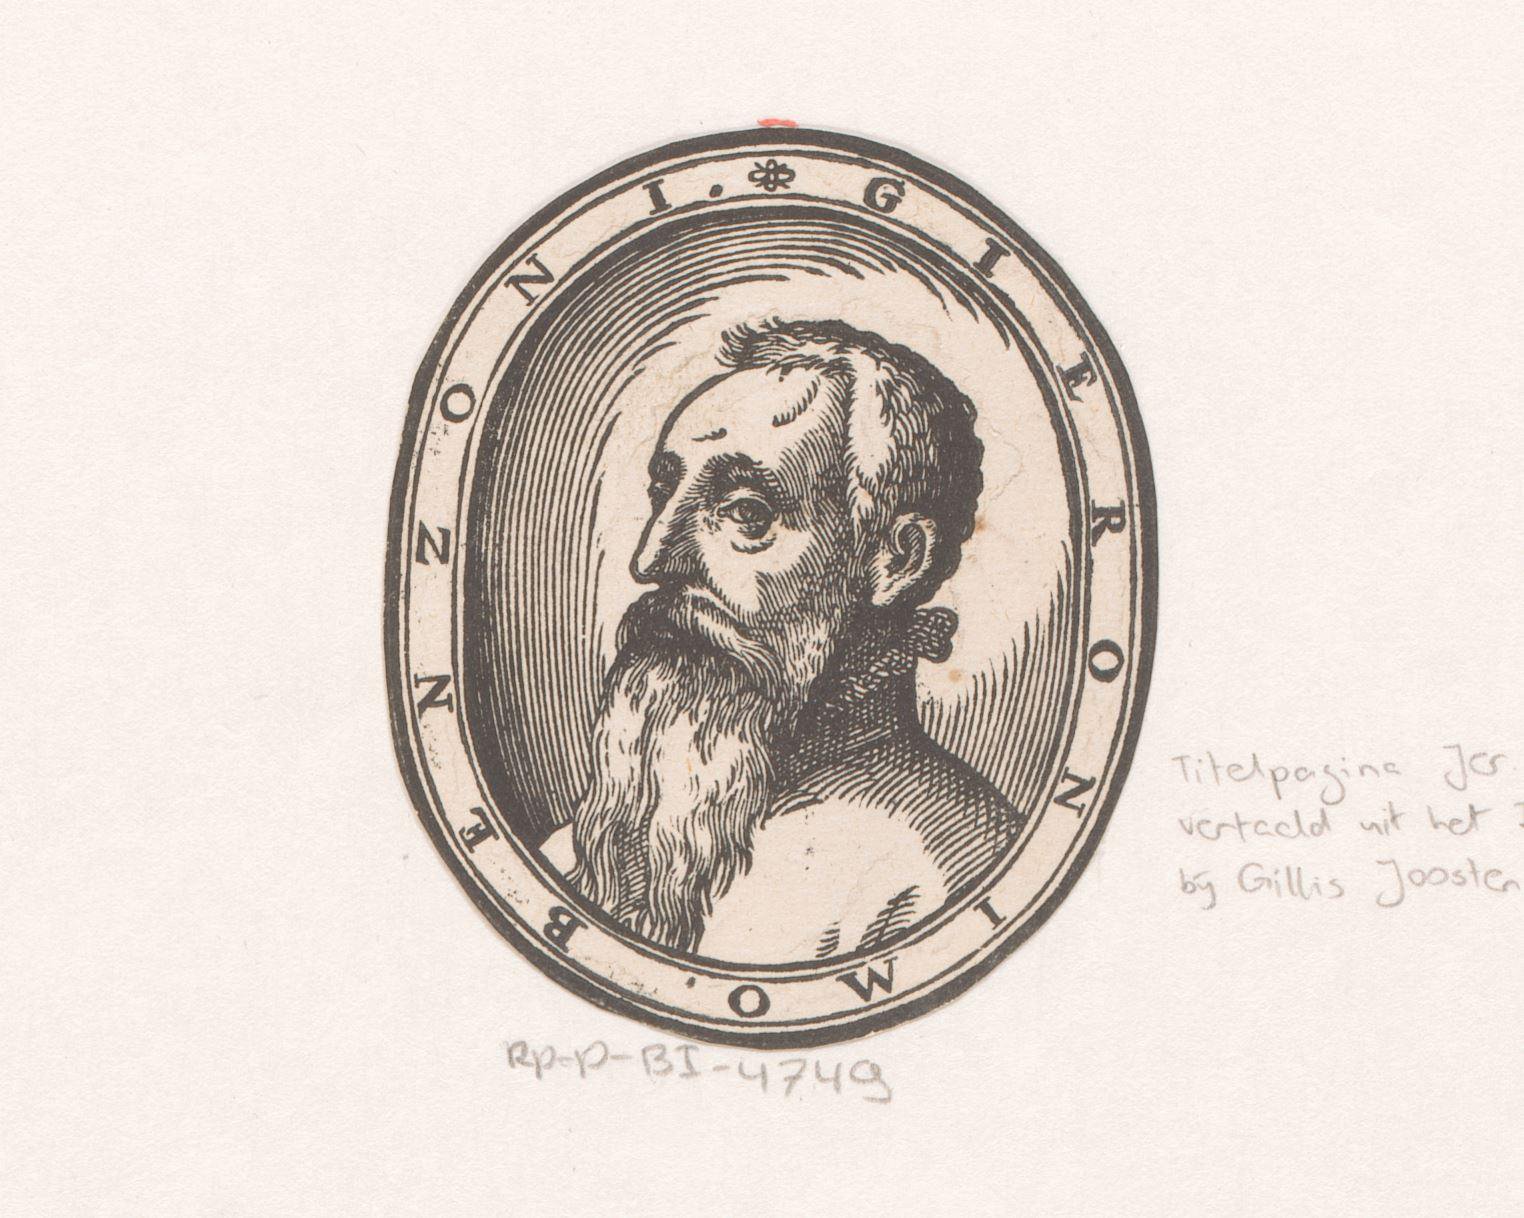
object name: titelblad, titelpagina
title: Fragment titelpagina voor: Girolamo Benzoni, Beschryvinghe van West-Indien, waer in verhaelt wordt, de eerste vindingh van de eylanden, 1661-1666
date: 1661-1666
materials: paper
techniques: woodcut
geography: amsterdam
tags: milaan, schrijver, girolamo benzoni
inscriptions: collector's mark: Lugt 240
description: Fragment titelpagina voor: Benzoni, Girolamo. Beschryvinghe van West-Indien, waer in verhaelt wordt, de eerste vindingh van de eylanden. Amsterdam: Gillis Joosten Saeghman, 1661-1666.